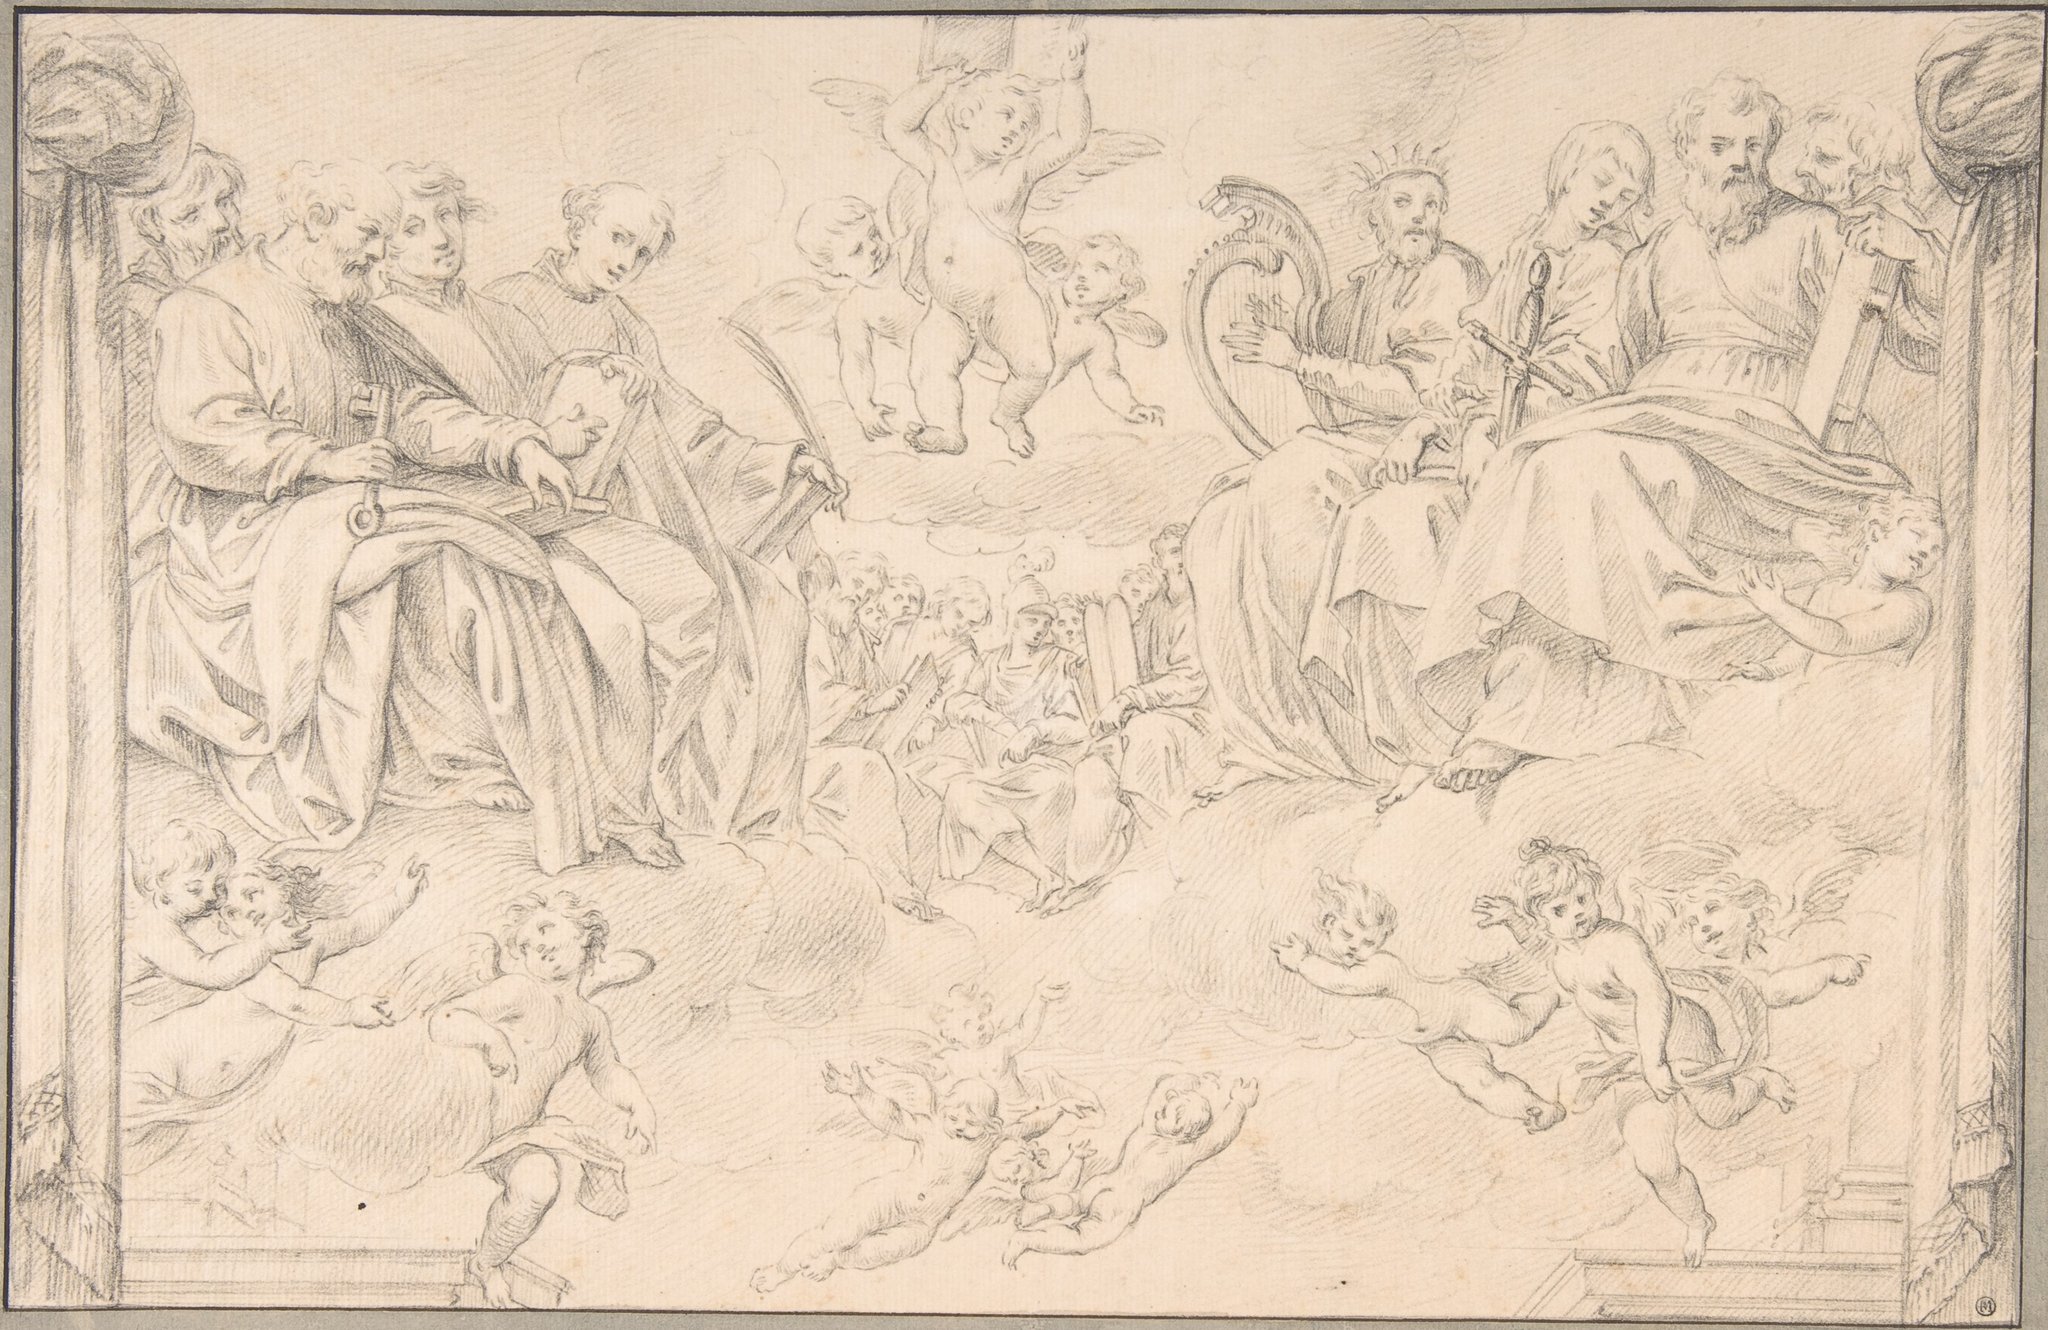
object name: drawing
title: Prophets and Saints in Glory, after Bernardino Poccetti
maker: santi pacini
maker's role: artist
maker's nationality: italian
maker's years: 1735-1790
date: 1735-1790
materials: chalk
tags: men,saints